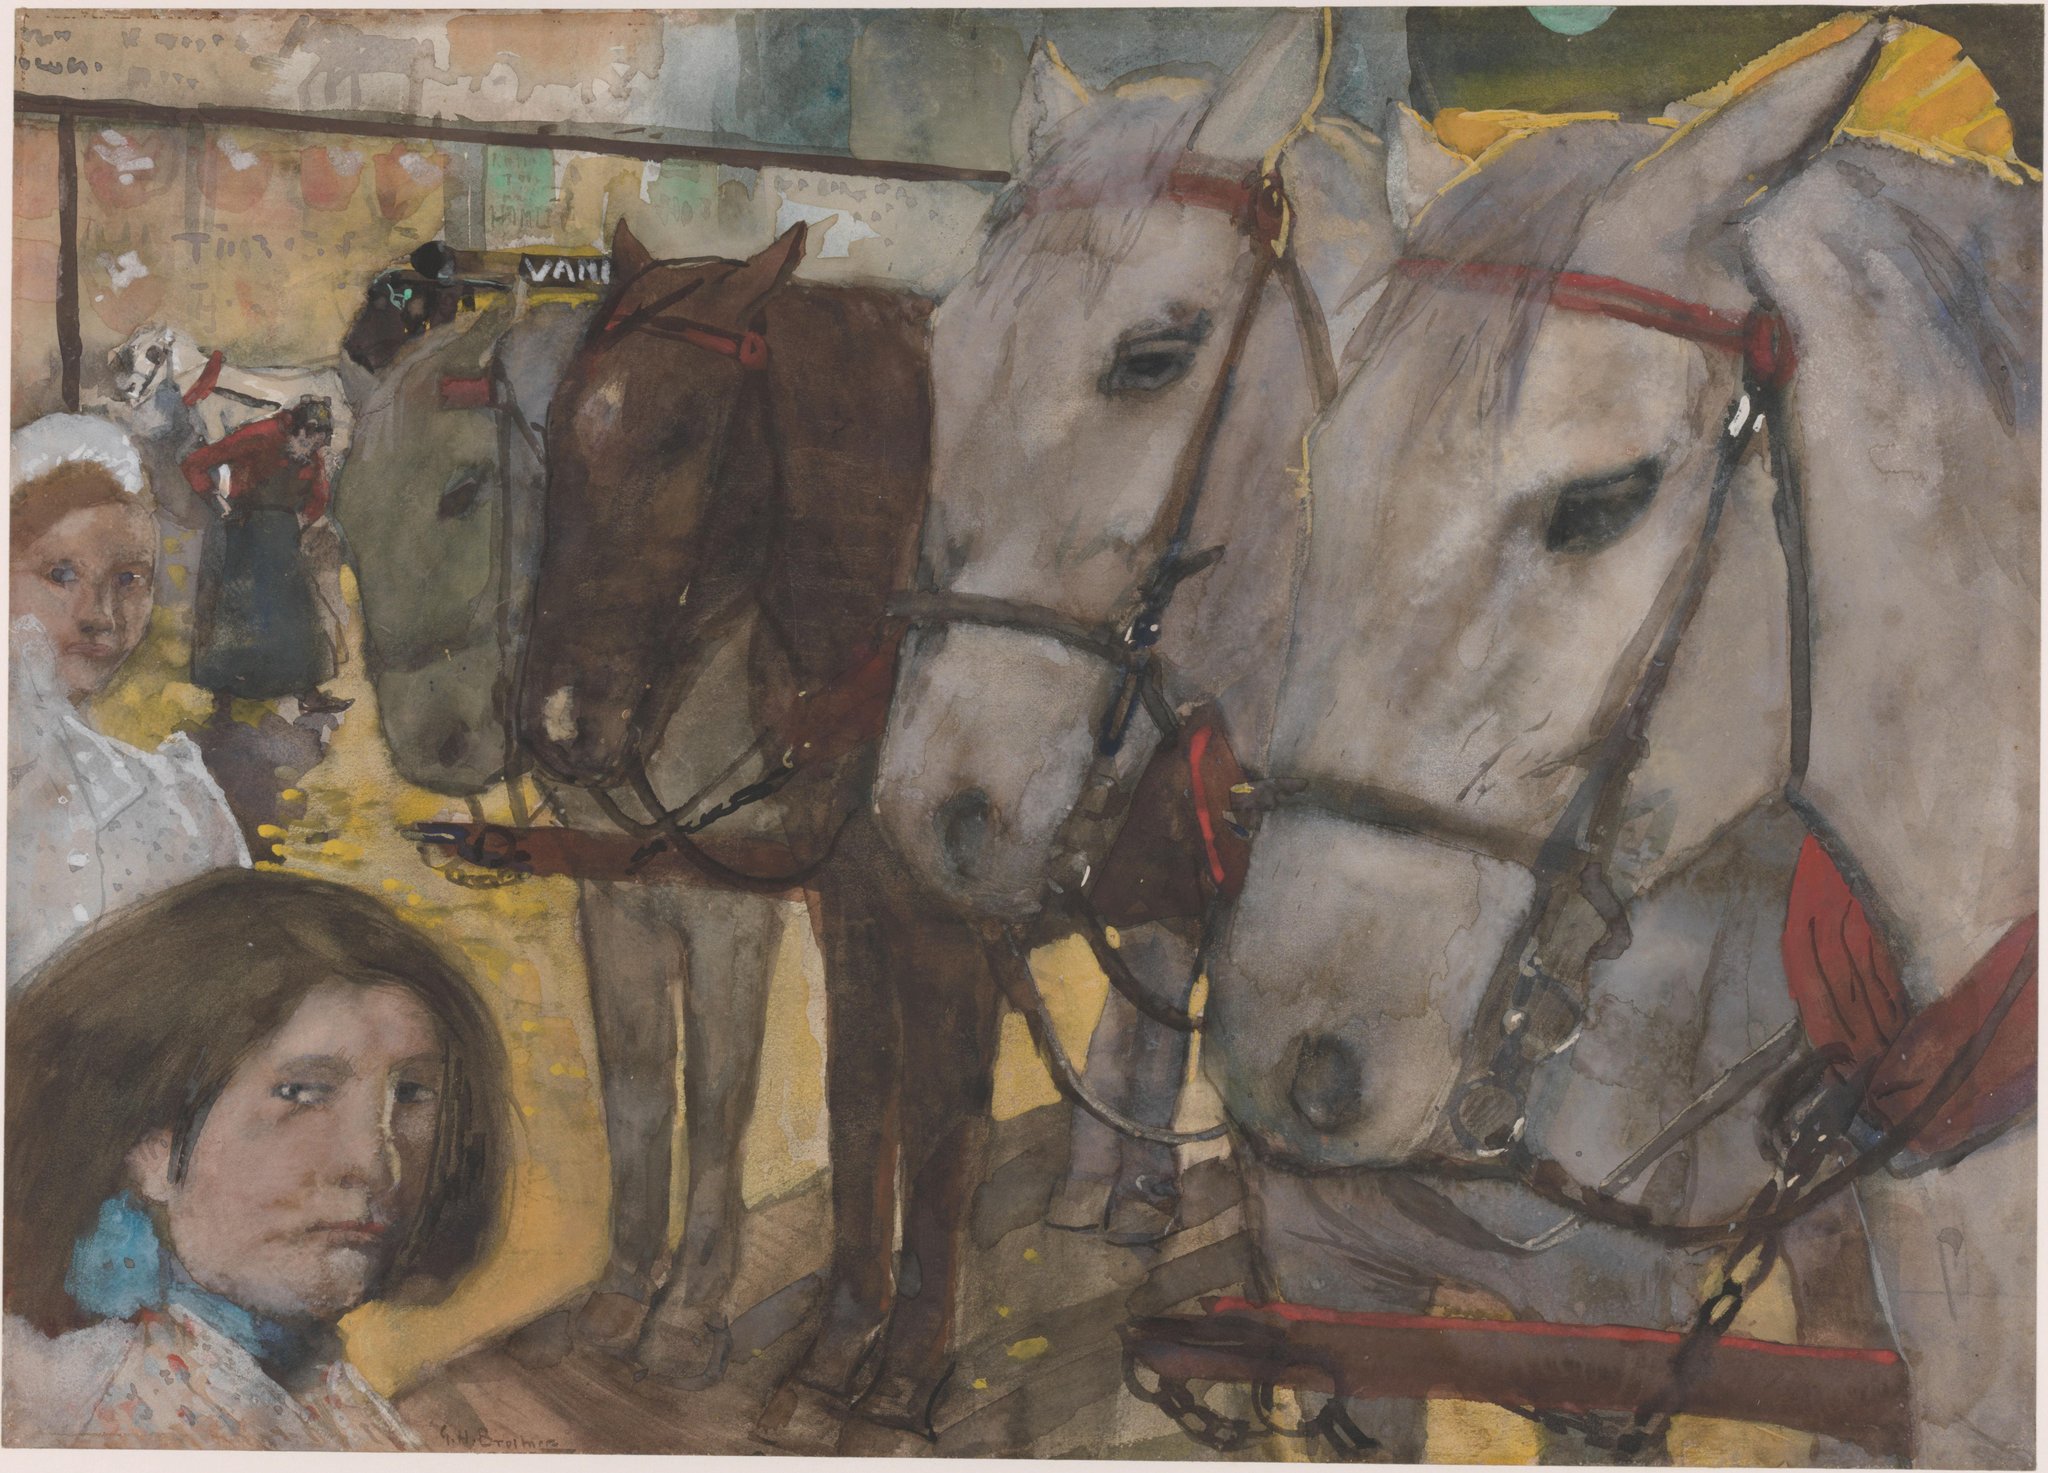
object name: watercolor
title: Trampaarden op de Dam te Amsterdam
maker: george hendrik breitner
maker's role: draughtsman, painter, print maker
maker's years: 1857-1923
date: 1893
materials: paper, watercolor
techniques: brush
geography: netherlands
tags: diligence, omnibus, horse-tram, horse